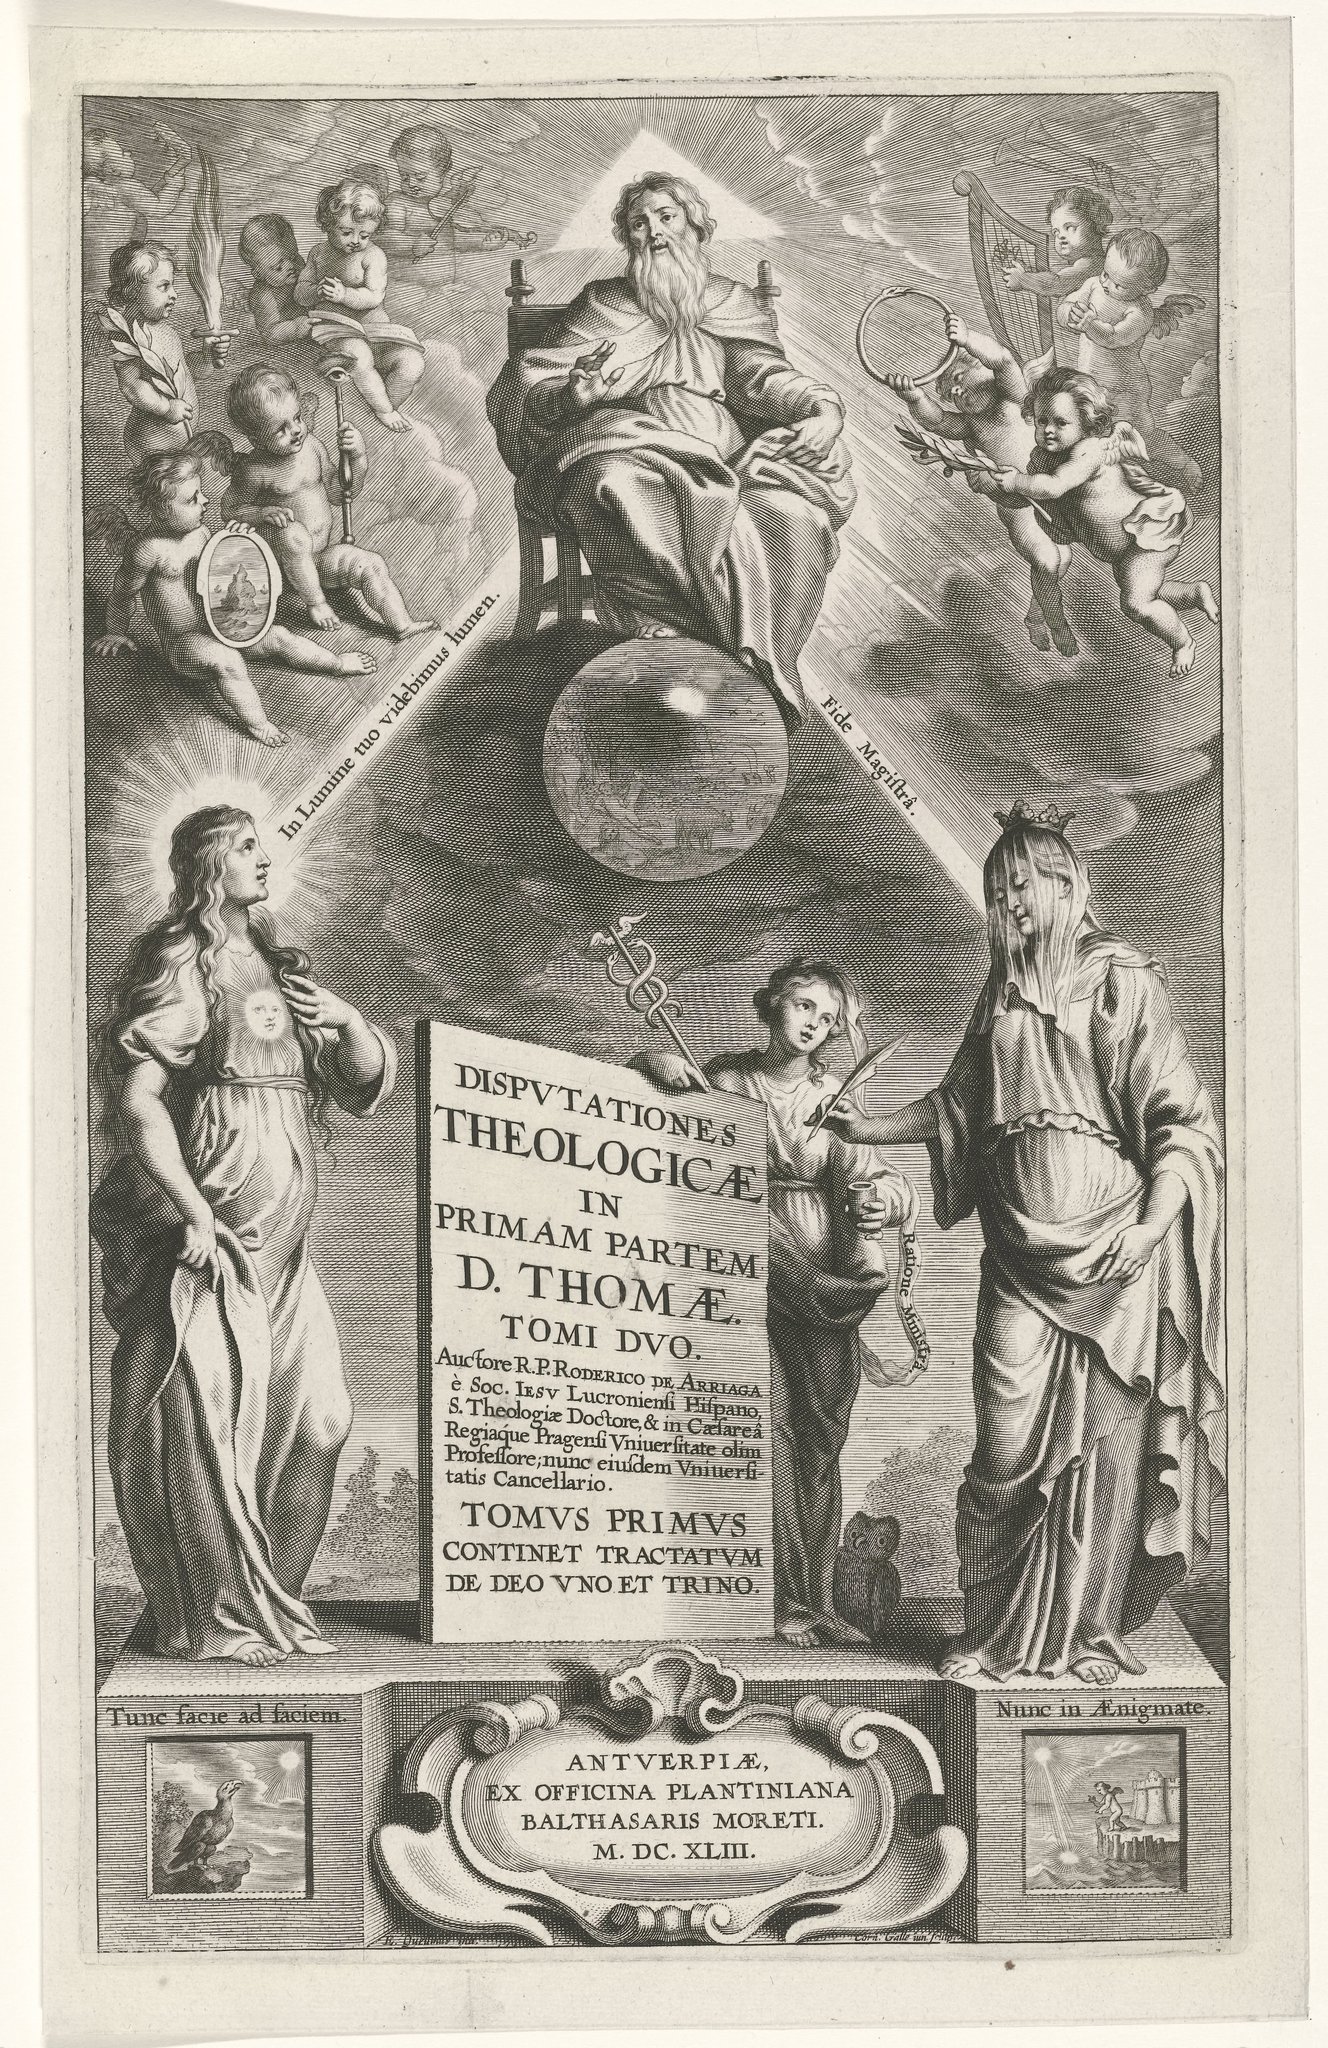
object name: titelblad, titelpagina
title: Titelpagina voor: Rodrigo de Arriaga, Disputationes theologicae. Antwerpen: 1643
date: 1643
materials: paper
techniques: engraving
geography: antwerp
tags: faith, 'fides'; 'fede', 'fede catholica', 'fede christiana', 'fede christiana catholica' (ripa) ~ one of the three theological virtues, god the father (as bearded old man) enthroned, usually with crown or tiara, and with sceptre and/or globe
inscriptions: collector's mark: Lugt 240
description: God de Vader zit op een stoel in de hemel. Hij rust met zijn voet op een globe waarop het paradijs te zien is. Op een sokkel staan de personificaties van Licht (links) en Geloof (rechts). Geloof schrijft met een veer de titel van het boek op een stenen plaat.